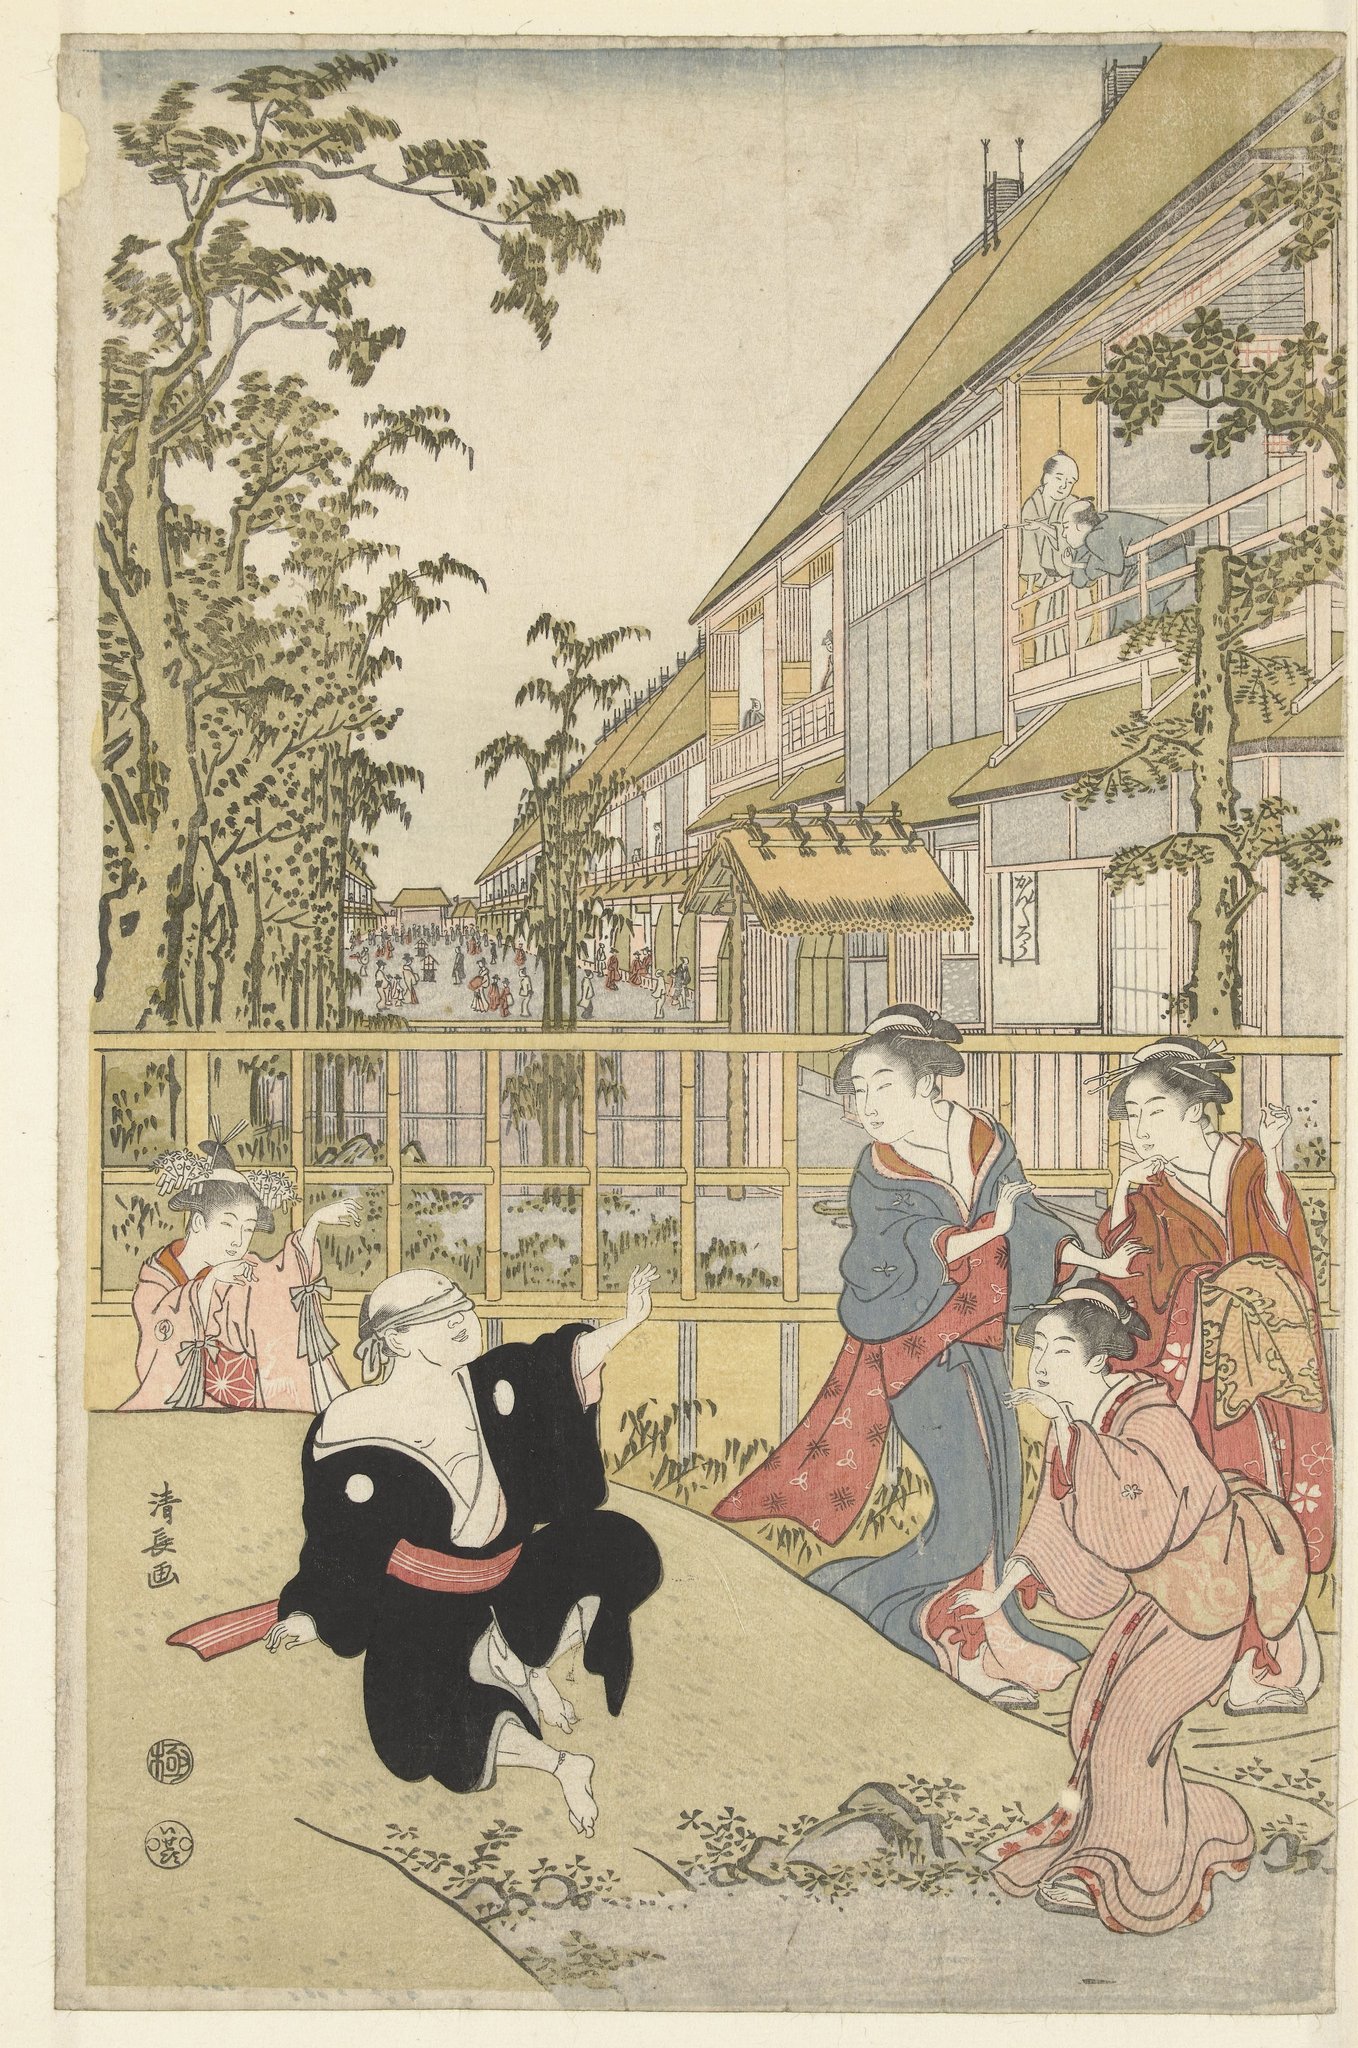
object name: print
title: Blindemannetje spelen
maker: torii kiyonaga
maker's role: draughtsman, print maker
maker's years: 1752-1815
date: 1792-1796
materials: paper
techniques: woodcut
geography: tokyo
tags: blind-man's buff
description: Geblinddoekte man in zwarte kimono, blindemannetje spelend met drie vrouwen en een meisje in de tuin van het Kankanro theehuis; op de achtergrond een gezicht op Nakanocho, de hoofdstraat van het Yoshiwara.